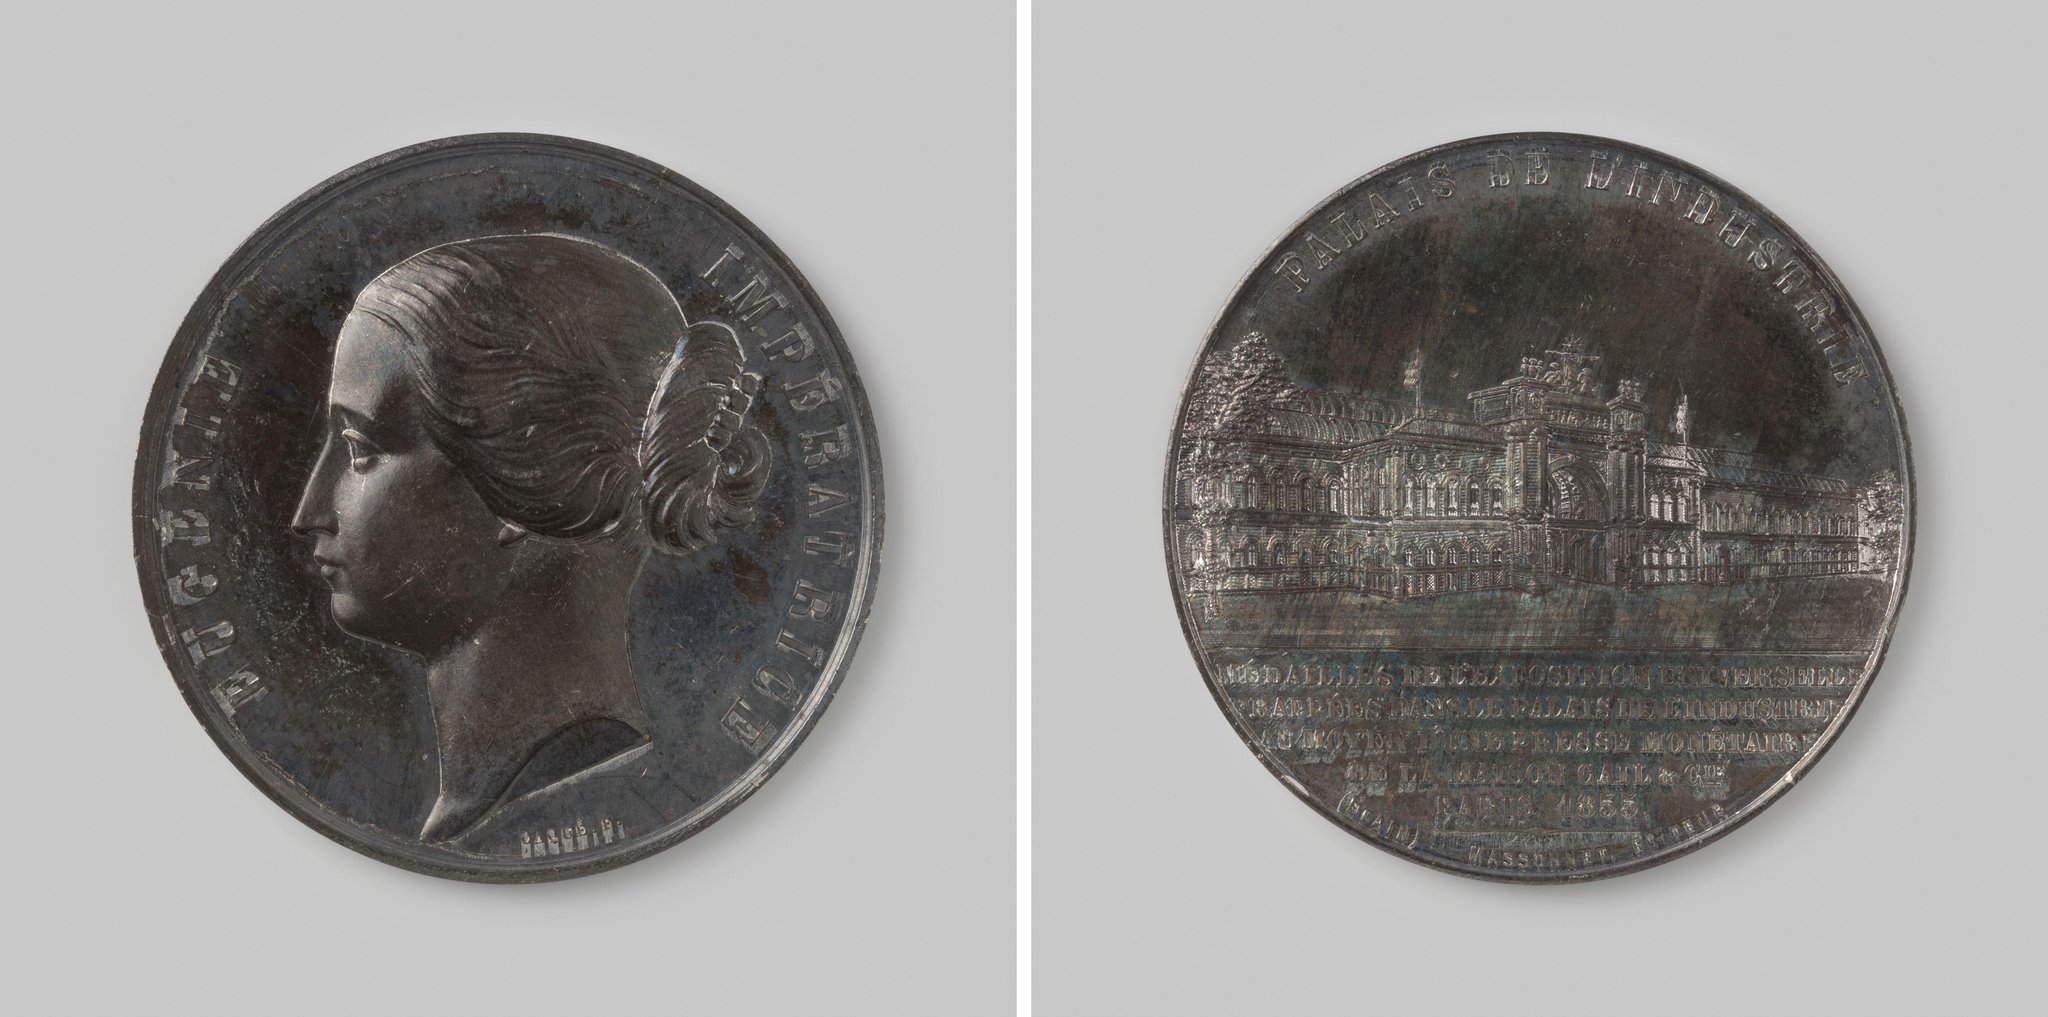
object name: history medal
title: Gail & Co slaat de erepenningen voor de Wereldtentoonstelling te Parijs 1855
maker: armand auguste caqué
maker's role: print maker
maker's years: 1795-1881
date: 1855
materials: tin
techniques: striking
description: Tinnen penning, op de voorzijde het portret van Keizerin Eugenie naar links met omschrift, op de keerzijde het tentoonstellingsgebouw met boven omschrift en onder vijf regels tekst.